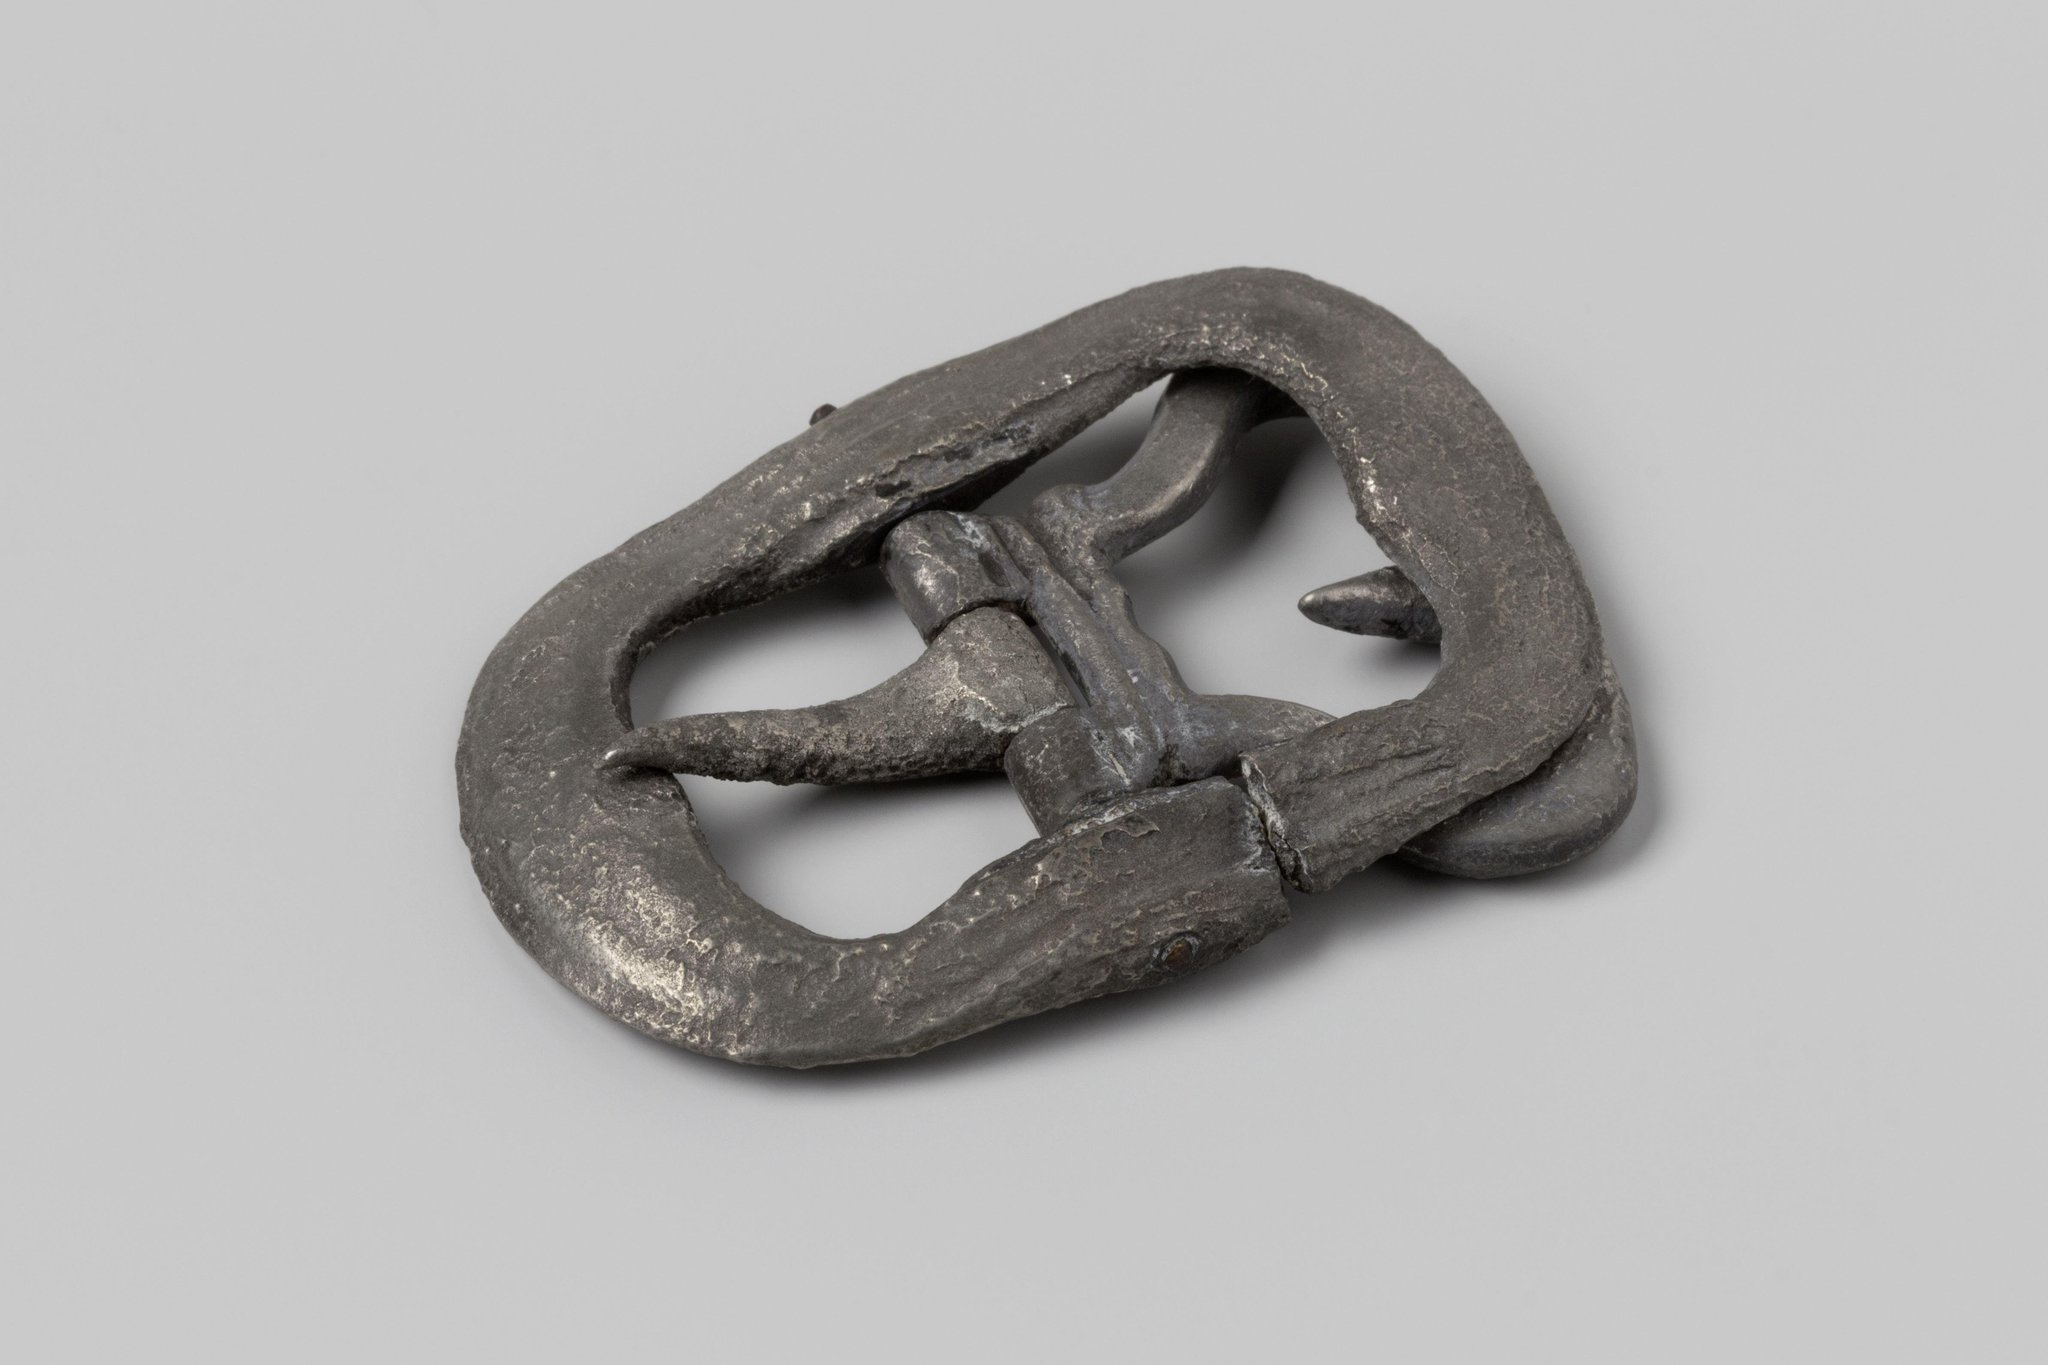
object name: shoe buckle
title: Schoengesp uit het wrak van de Oost-Indiëvaarder Hollandia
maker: Anonymous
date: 1700-1743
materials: tin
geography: netherlands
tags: verenigde oostindische compagnie, hollandia (schip), annet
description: Schoengesp. Buckle, chape buckle, shoe buckle; (4)fragm(1): (1) ring (5.9x4.1, 0.3t) squashed, moulded, (1) spindle, (1) tongue, (1) single-pronged loop.